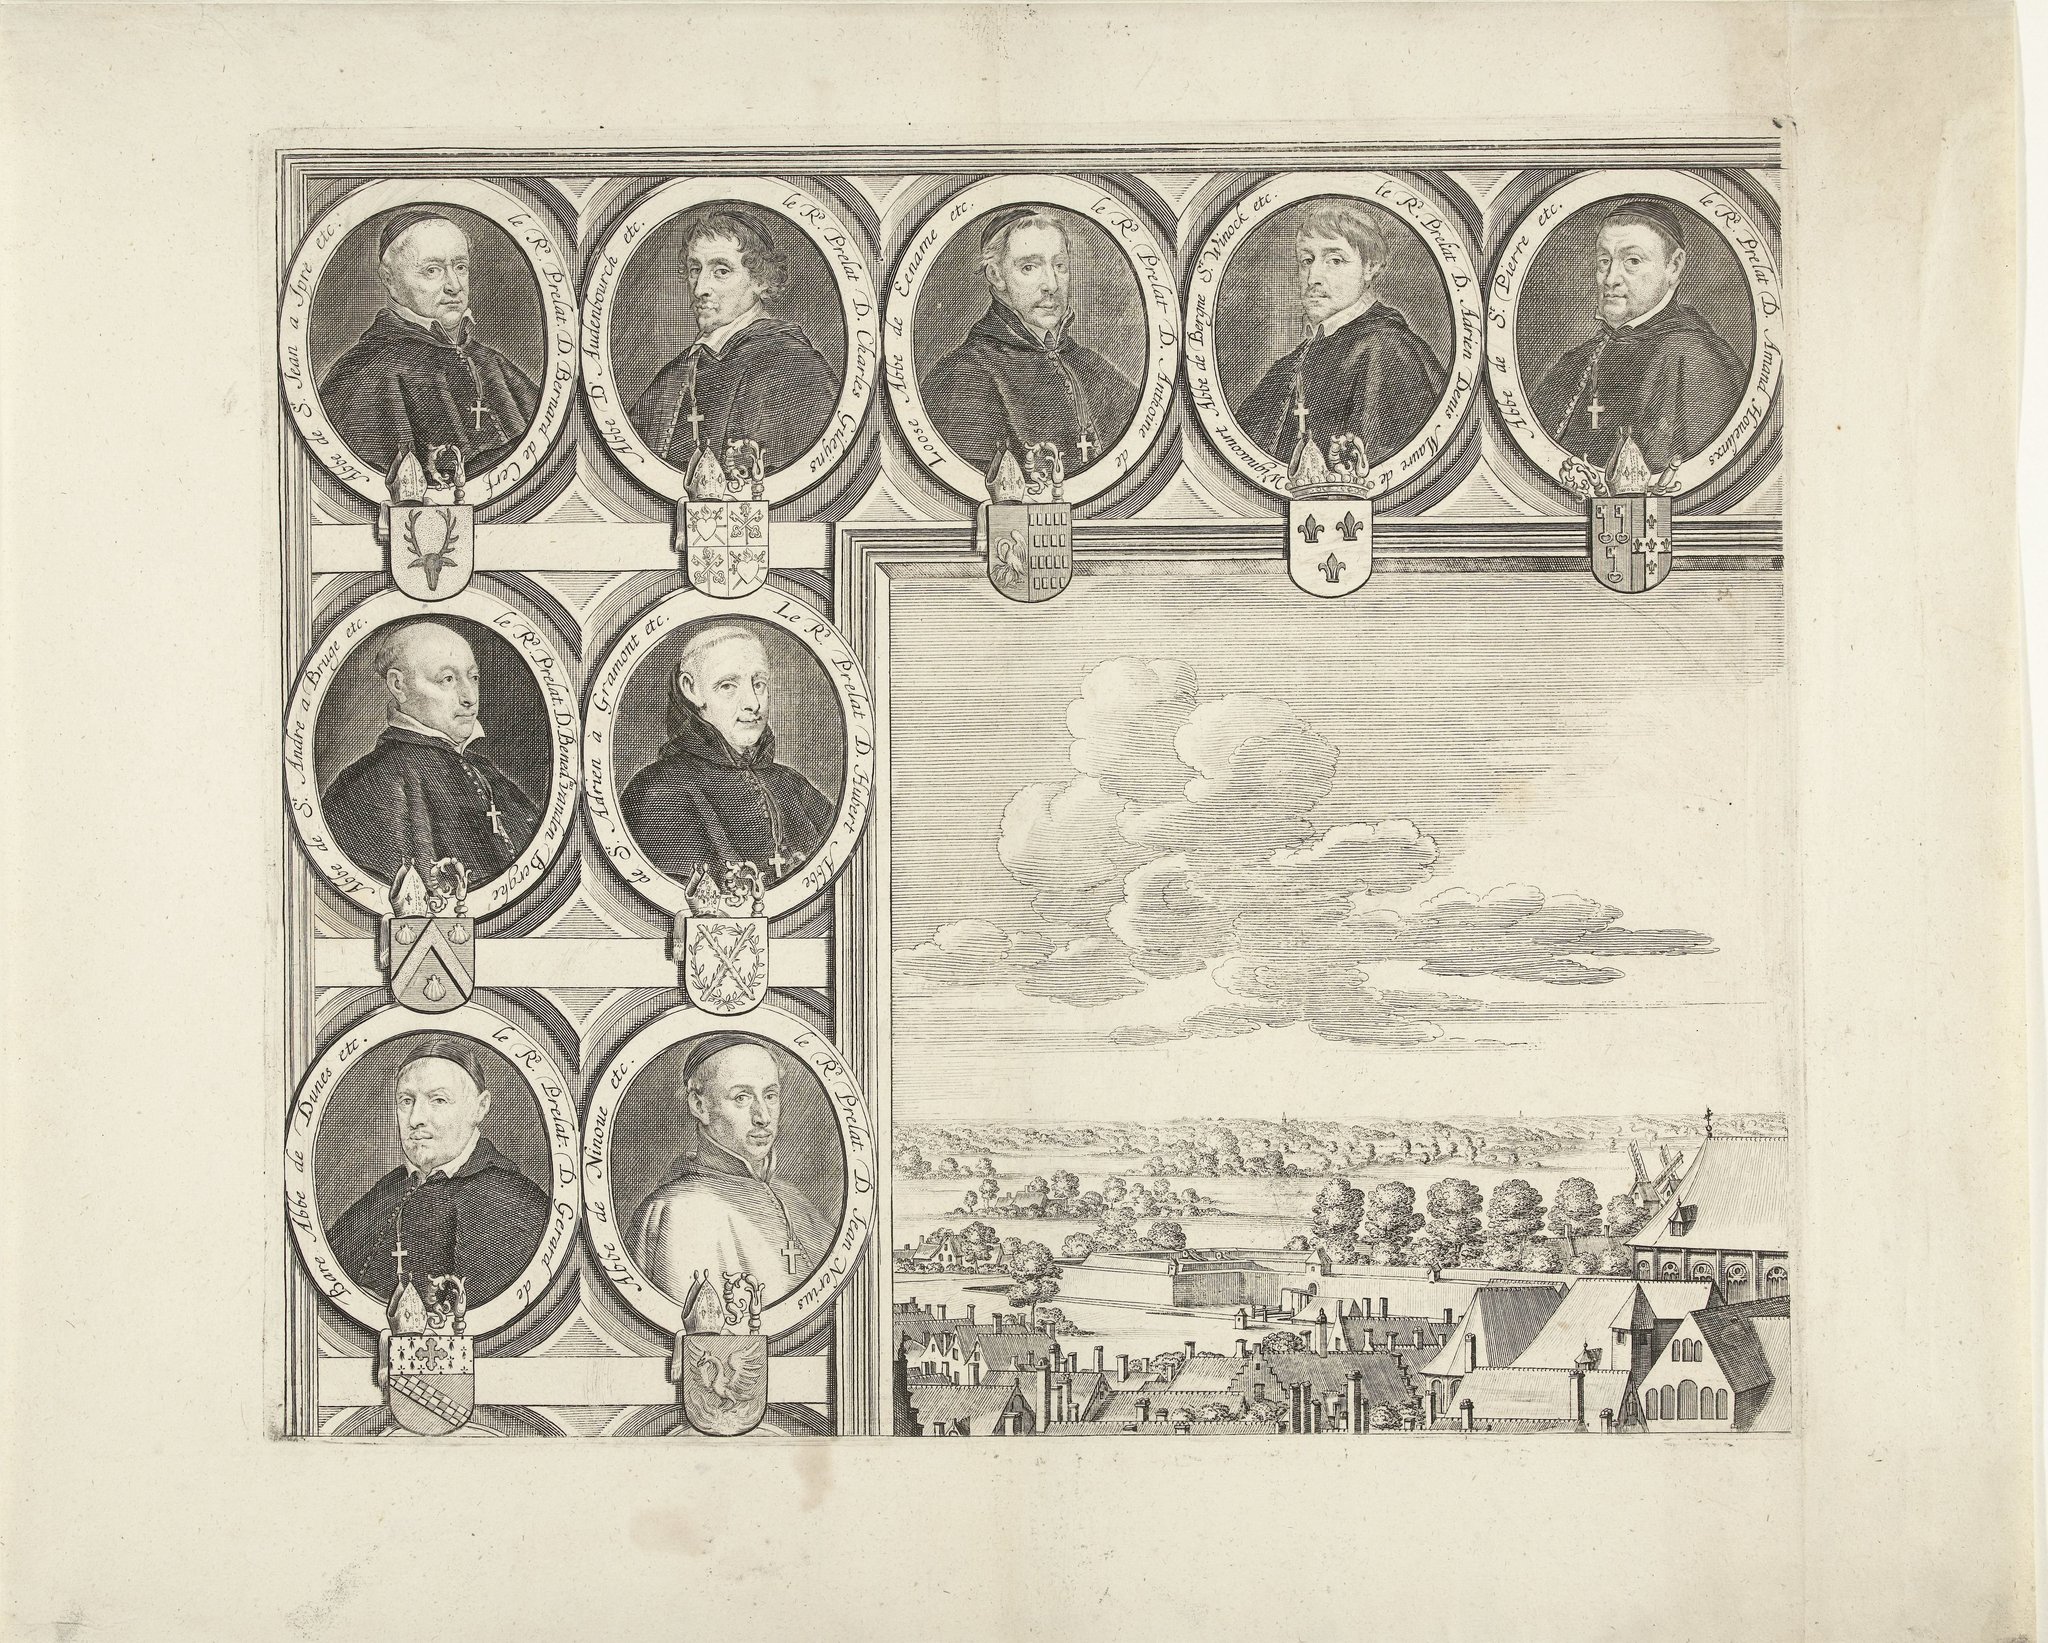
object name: print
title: Proclamatie te Gent van Karel II van Spanje als graaf van Vlaanderen (blad 1), 1666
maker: lucas vorsterman (ii)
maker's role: print maker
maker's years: 1624-1667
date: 1666-1667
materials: paper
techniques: engraving, etching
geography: southern netherlands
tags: karel ii (koning van spanje), ceremonial procession, parade, pageant ~ installation of a ruler, festivities (+ parade, pageant, cavalcade ~ festive activities)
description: Ceremonie op de Vrijdagmarkt te Gent bij de proclamatie van de Spaanse koning Karel II als graaf van Vlaanderen, 2 mei 1666. Blad 1 in een ongemonteerde ensemble van 12 platen van de ceremonie en cavalcade op het plein en 118 portretten van de hoogwaardigheidsbekleders die bij de plechtigheid aanwezig waren.